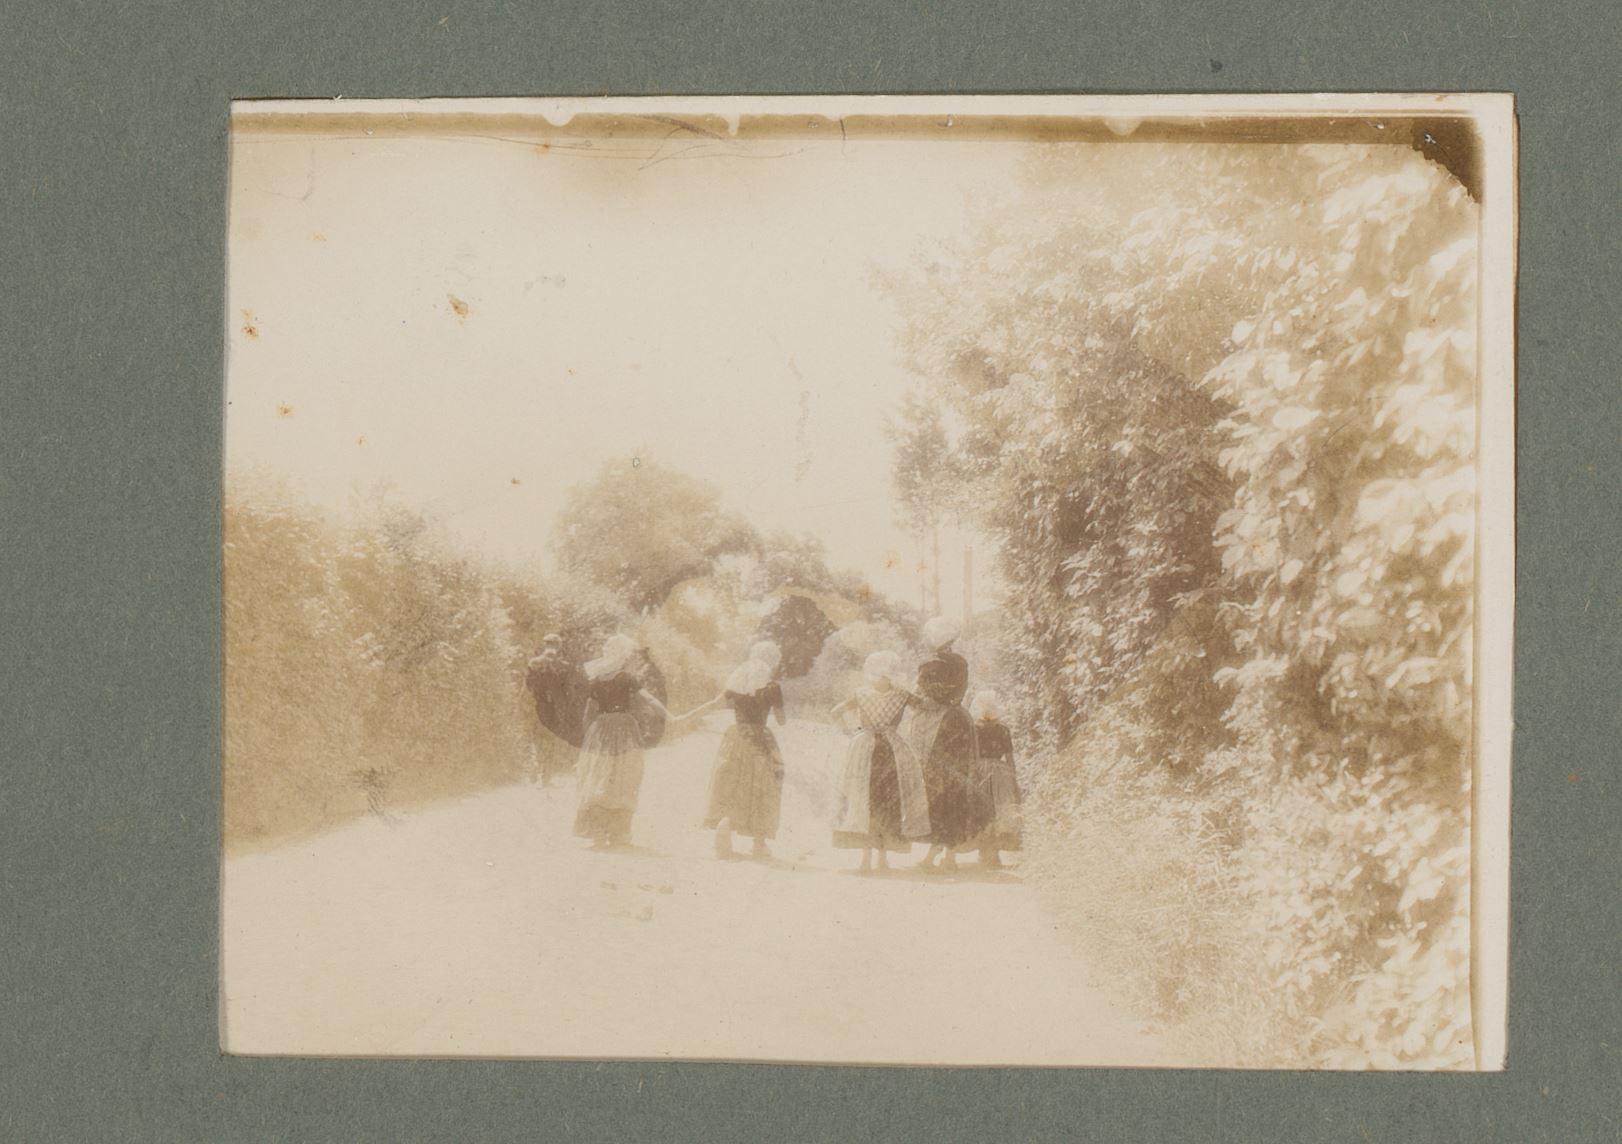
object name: photograph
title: Gezin in klederdracht, op de rug gezien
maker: george hidderley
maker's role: fotograaf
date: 1920-1940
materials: photographic support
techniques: gelatin silver print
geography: netherlands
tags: family group, especially parents with their child(ren), historical persons, road, path, folk costume, regional costume